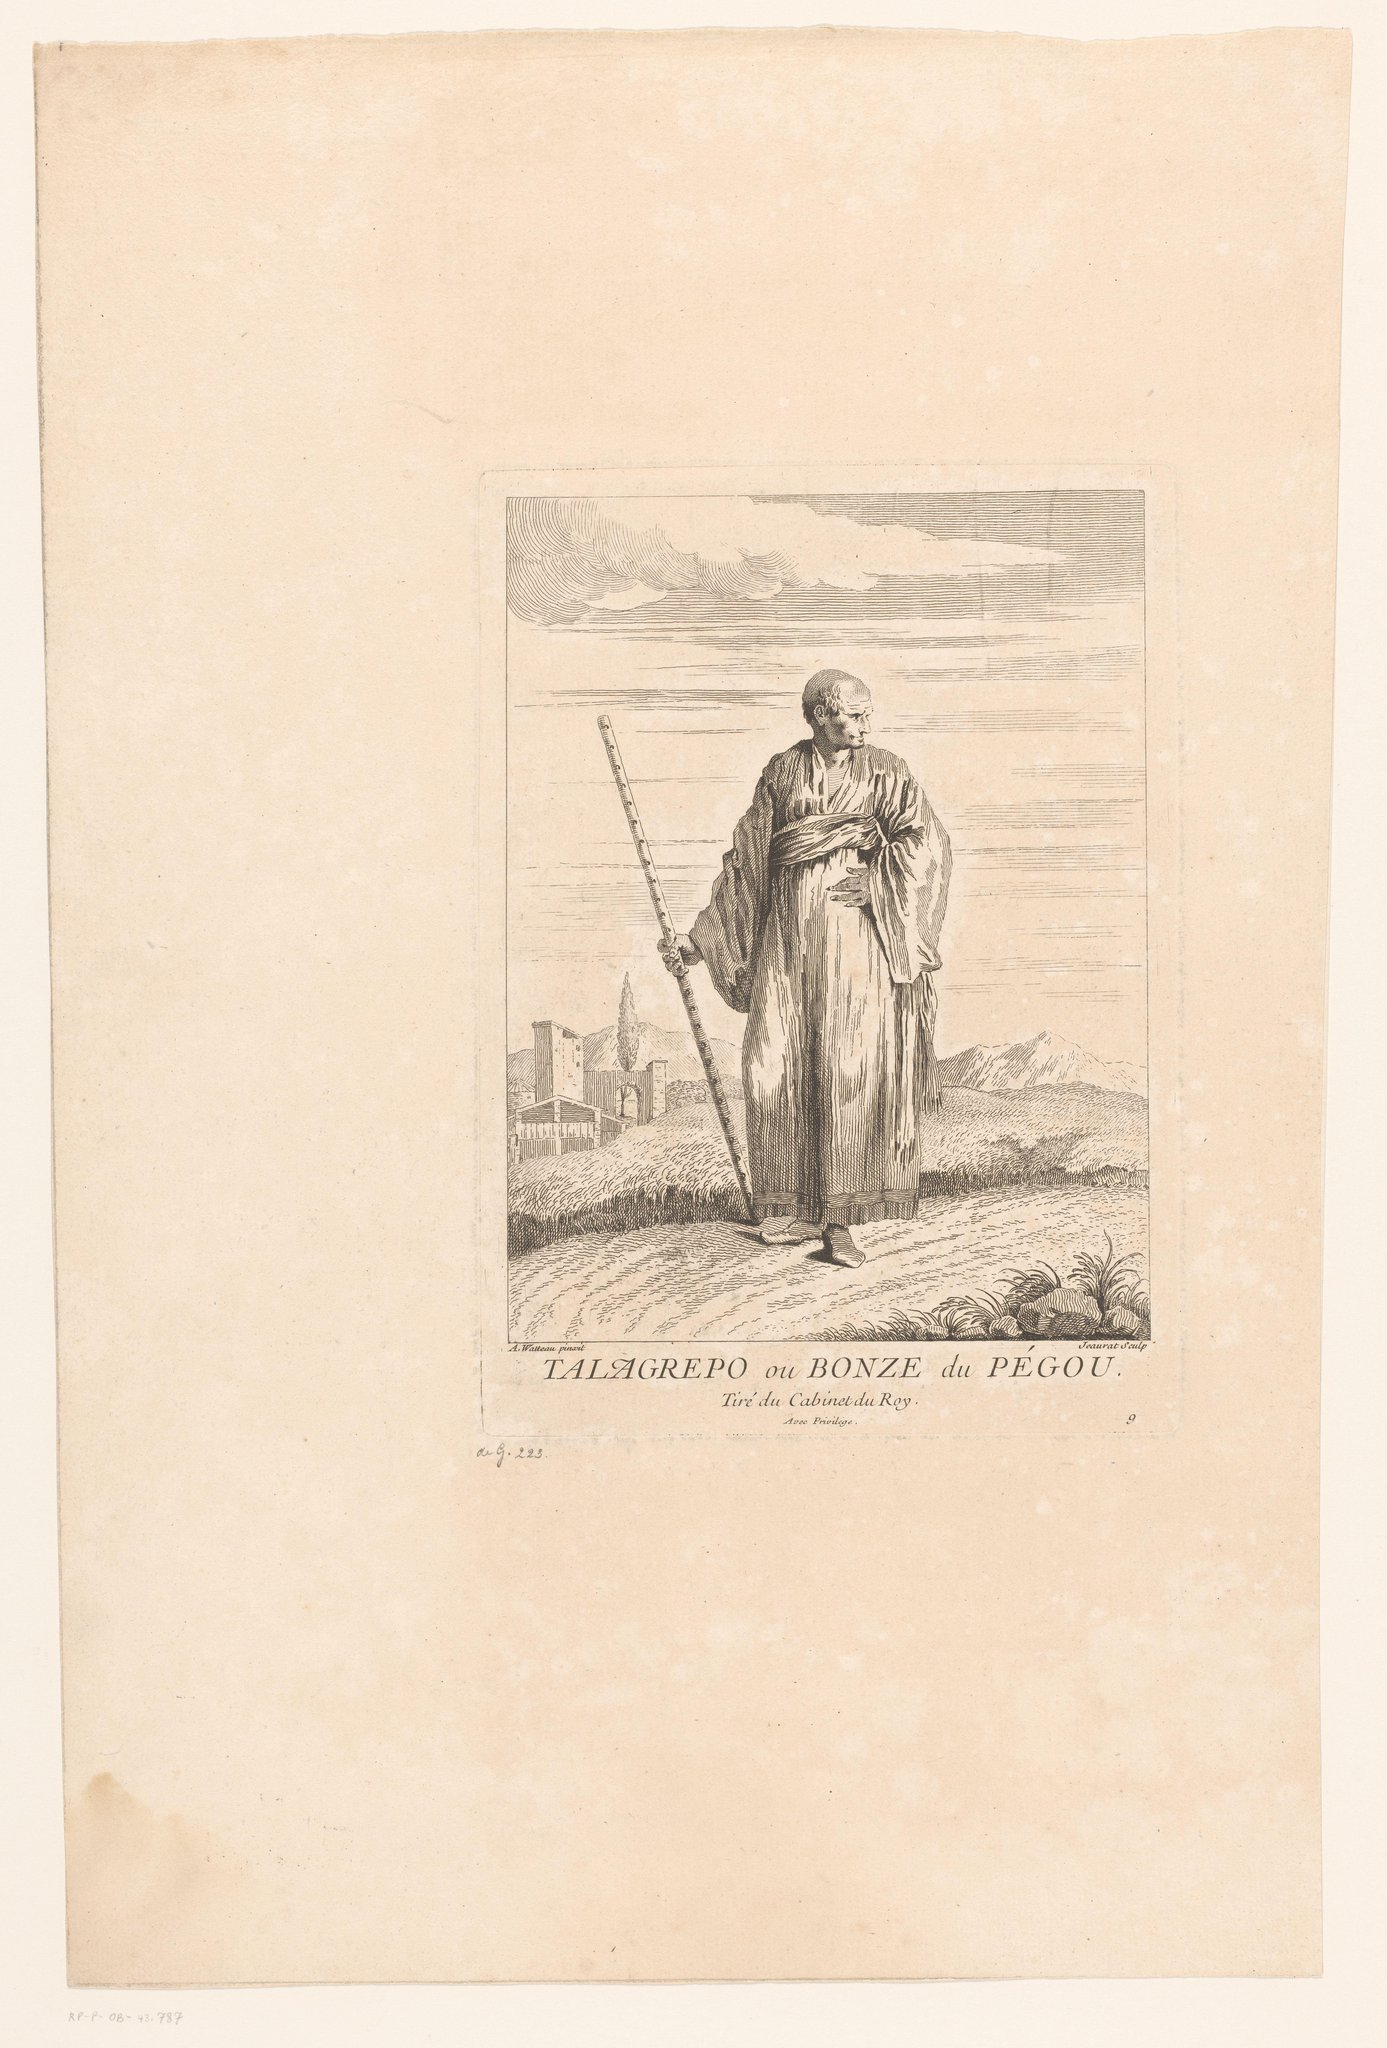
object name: print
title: Prenten naar Antoine Watteau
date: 1731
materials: paper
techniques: engraving, etching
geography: france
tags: chinese (+ costume)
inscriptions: collector's mark: Lugt 2228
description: Plaat 255 uit 'L'Oeuvre d'Antoine Watteau', een serie van 271 platen, inclusief twee titelprenten, naar schilderijen door Watteau en verzameld door Jean de Jullienne. Maakt ook deel uit van een serie van 30 prenten over Chinese kostuums en van een subserie van 12 prenten gemaakt door Jeaurat.